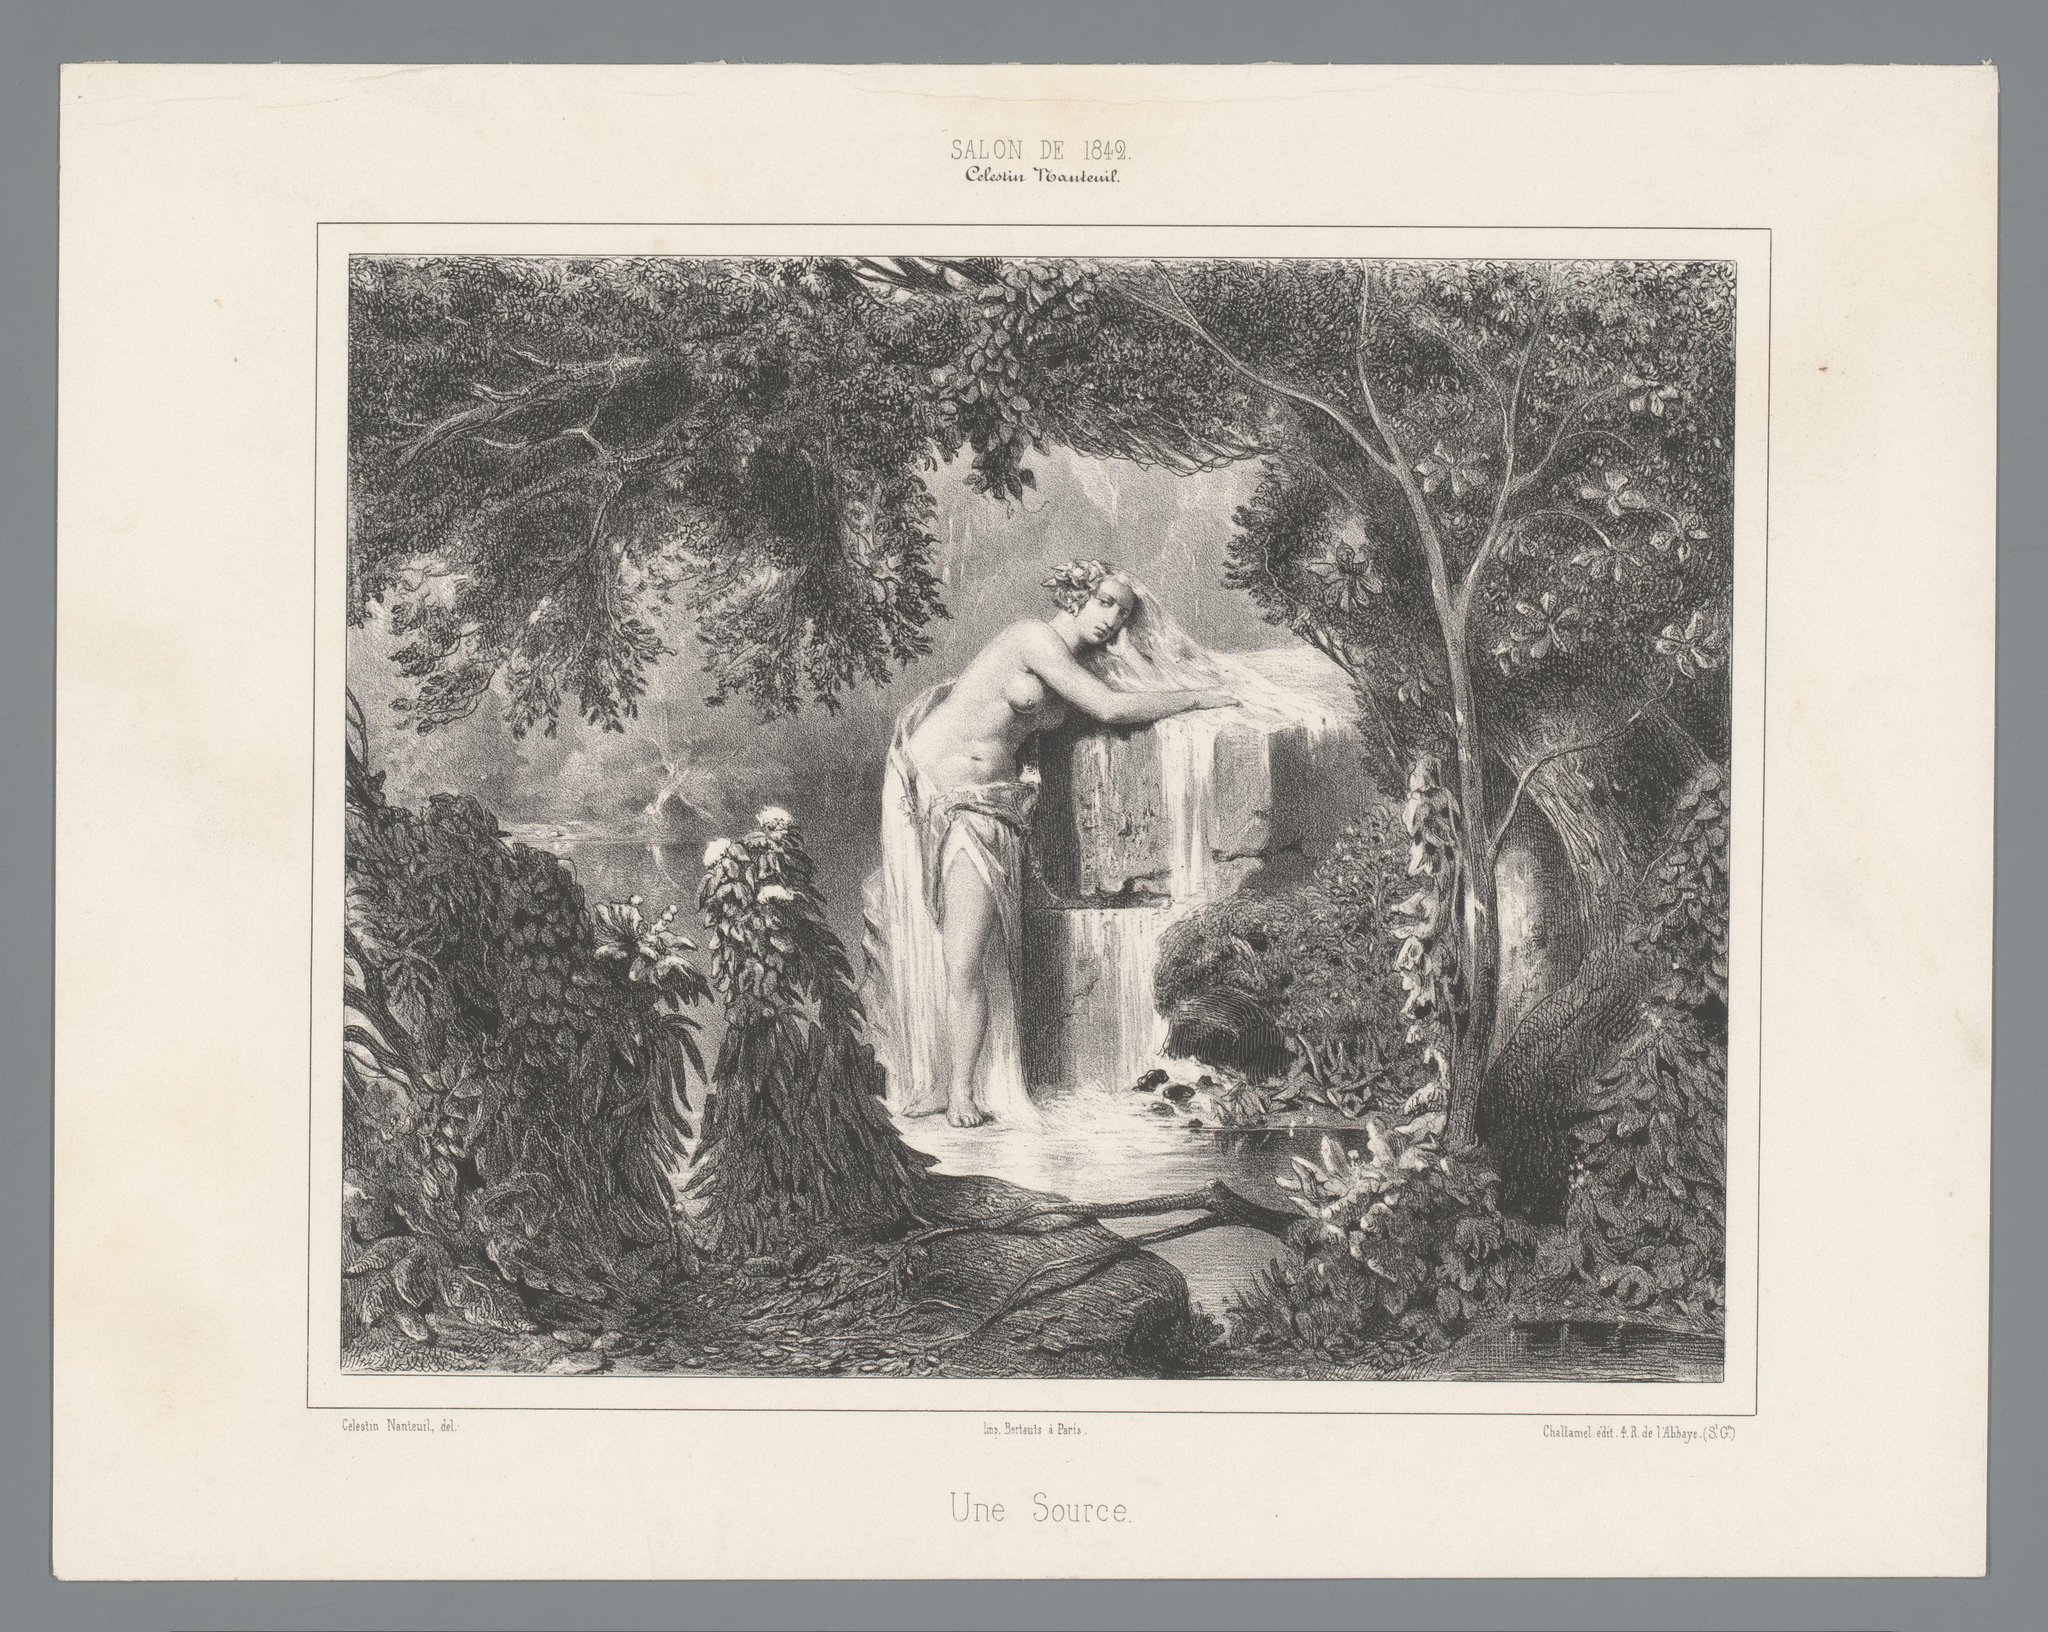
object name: print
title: Une source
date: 1842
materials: paper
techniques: lithograph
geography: paris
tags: nymphs (in general); 'ninfe in commune' (ripa), forest, wood, spring, source of river or stream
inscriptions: collector's mark: Lugt 2760, collector's mark: Lugt 2228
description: Prent gebruikt in: Ténint, Wilhelm. Album du Salon de 1842. Collection des principaux ouvrages exposés au Louvre (…). Parijs: Augustin Challamel, 1842.